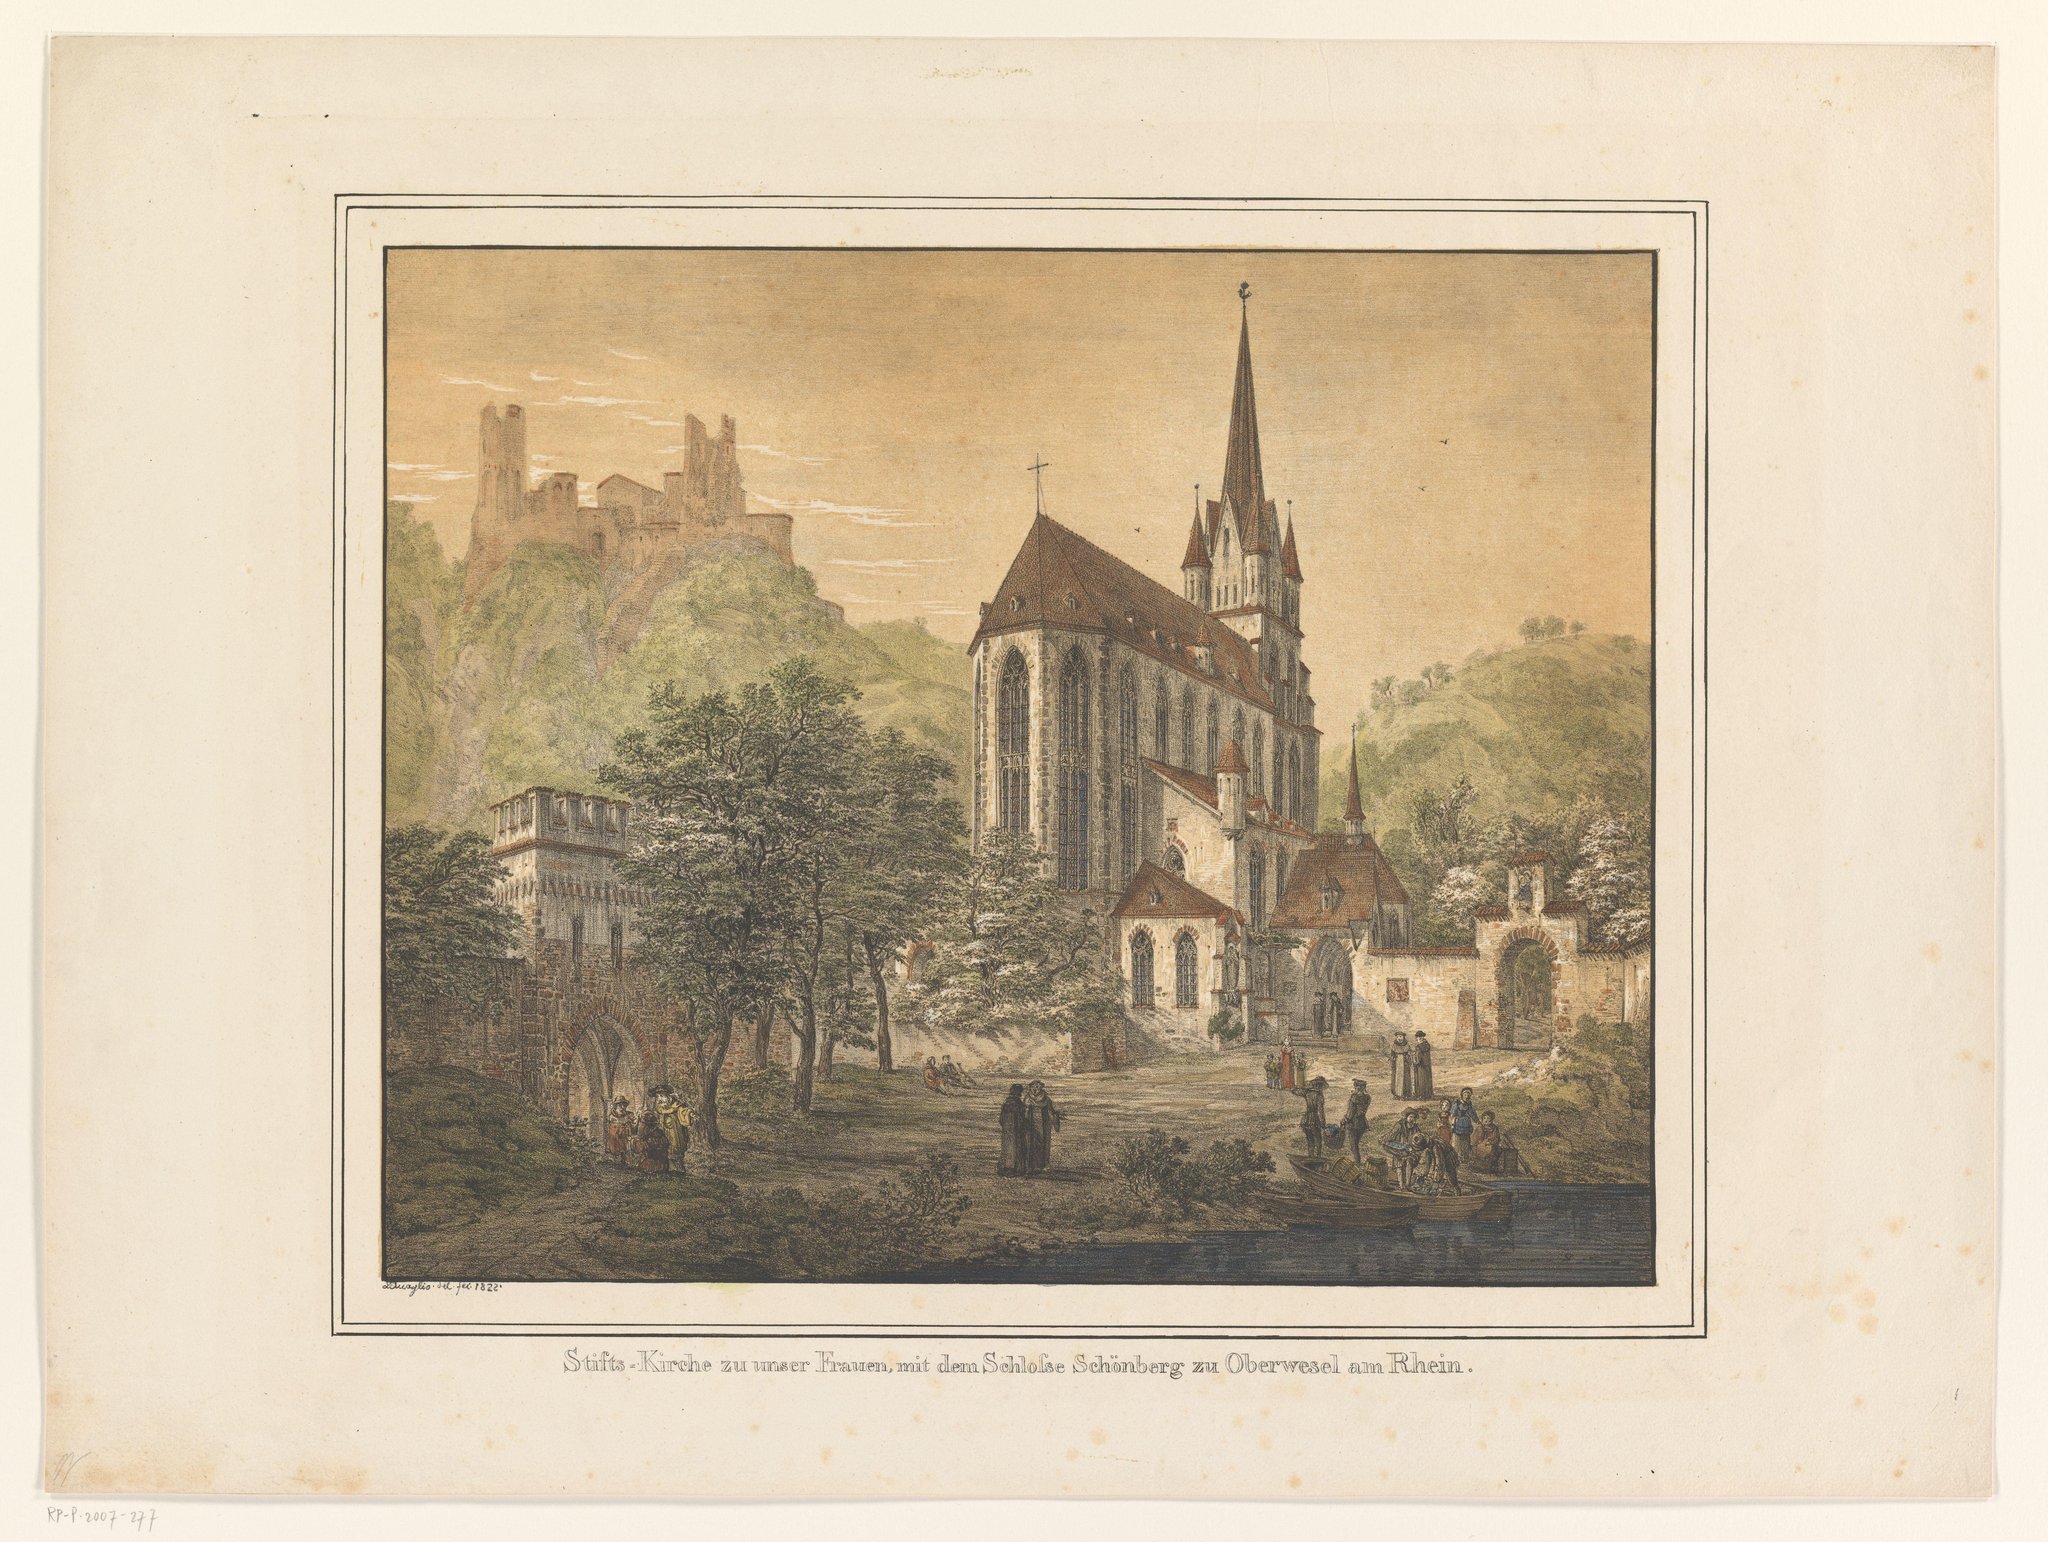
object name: print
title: Gezicht op de kerk en het kasteel te Oberwesel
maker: domenico quaglio (ii)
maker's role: painter, print maker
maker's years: 1787-1837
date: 1822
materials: paper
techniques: hand coloring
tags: church (exterior), landscape with tower or castle (+ city(-scape) with figures, staffage)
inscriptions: collector's mark: Lugt 2228, collector's mark: Lugt 2760